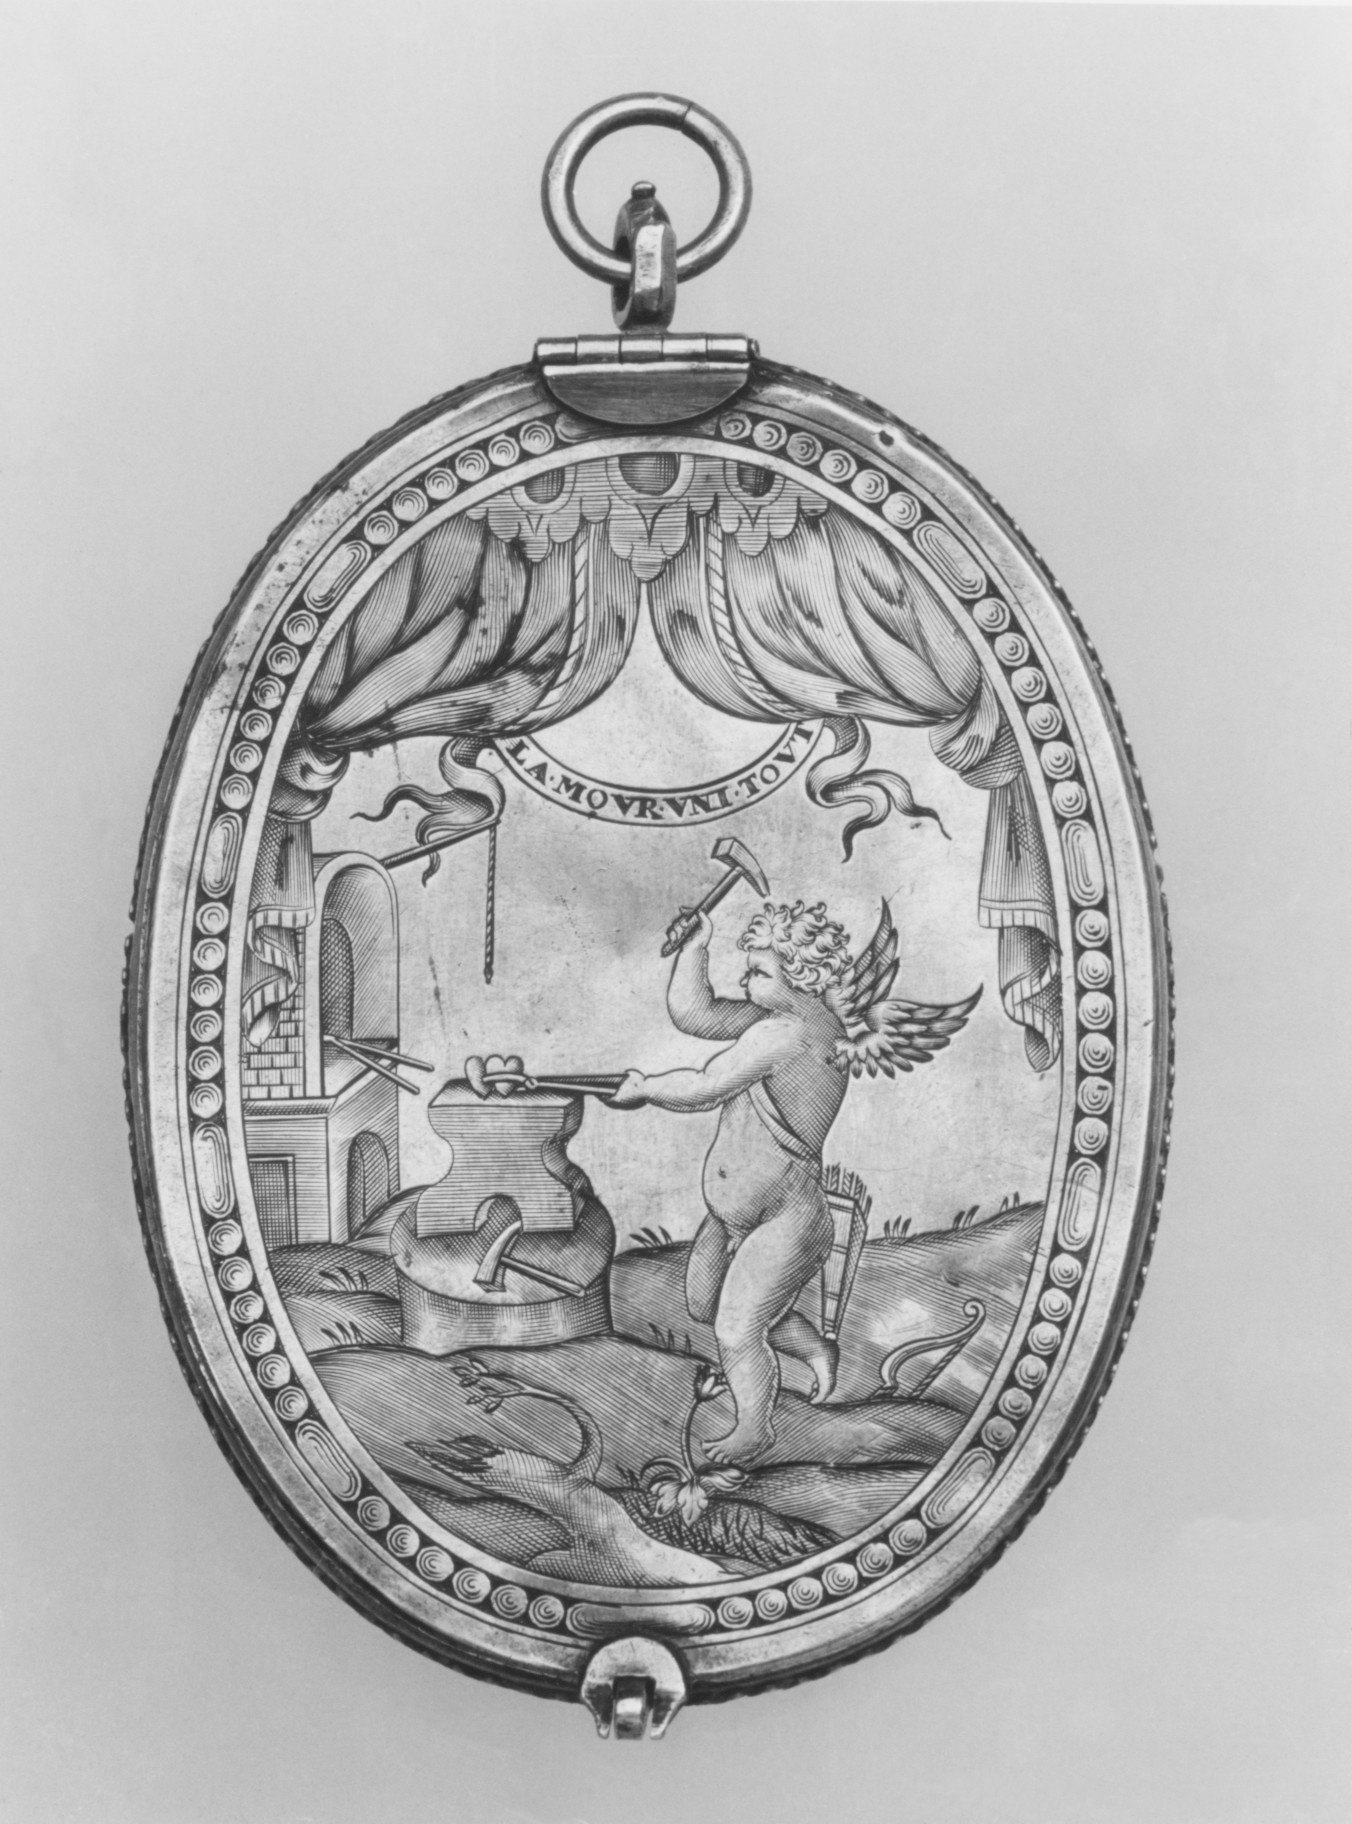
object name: mirror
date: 1601-1700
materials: silver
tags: hearts,cupid,hammers